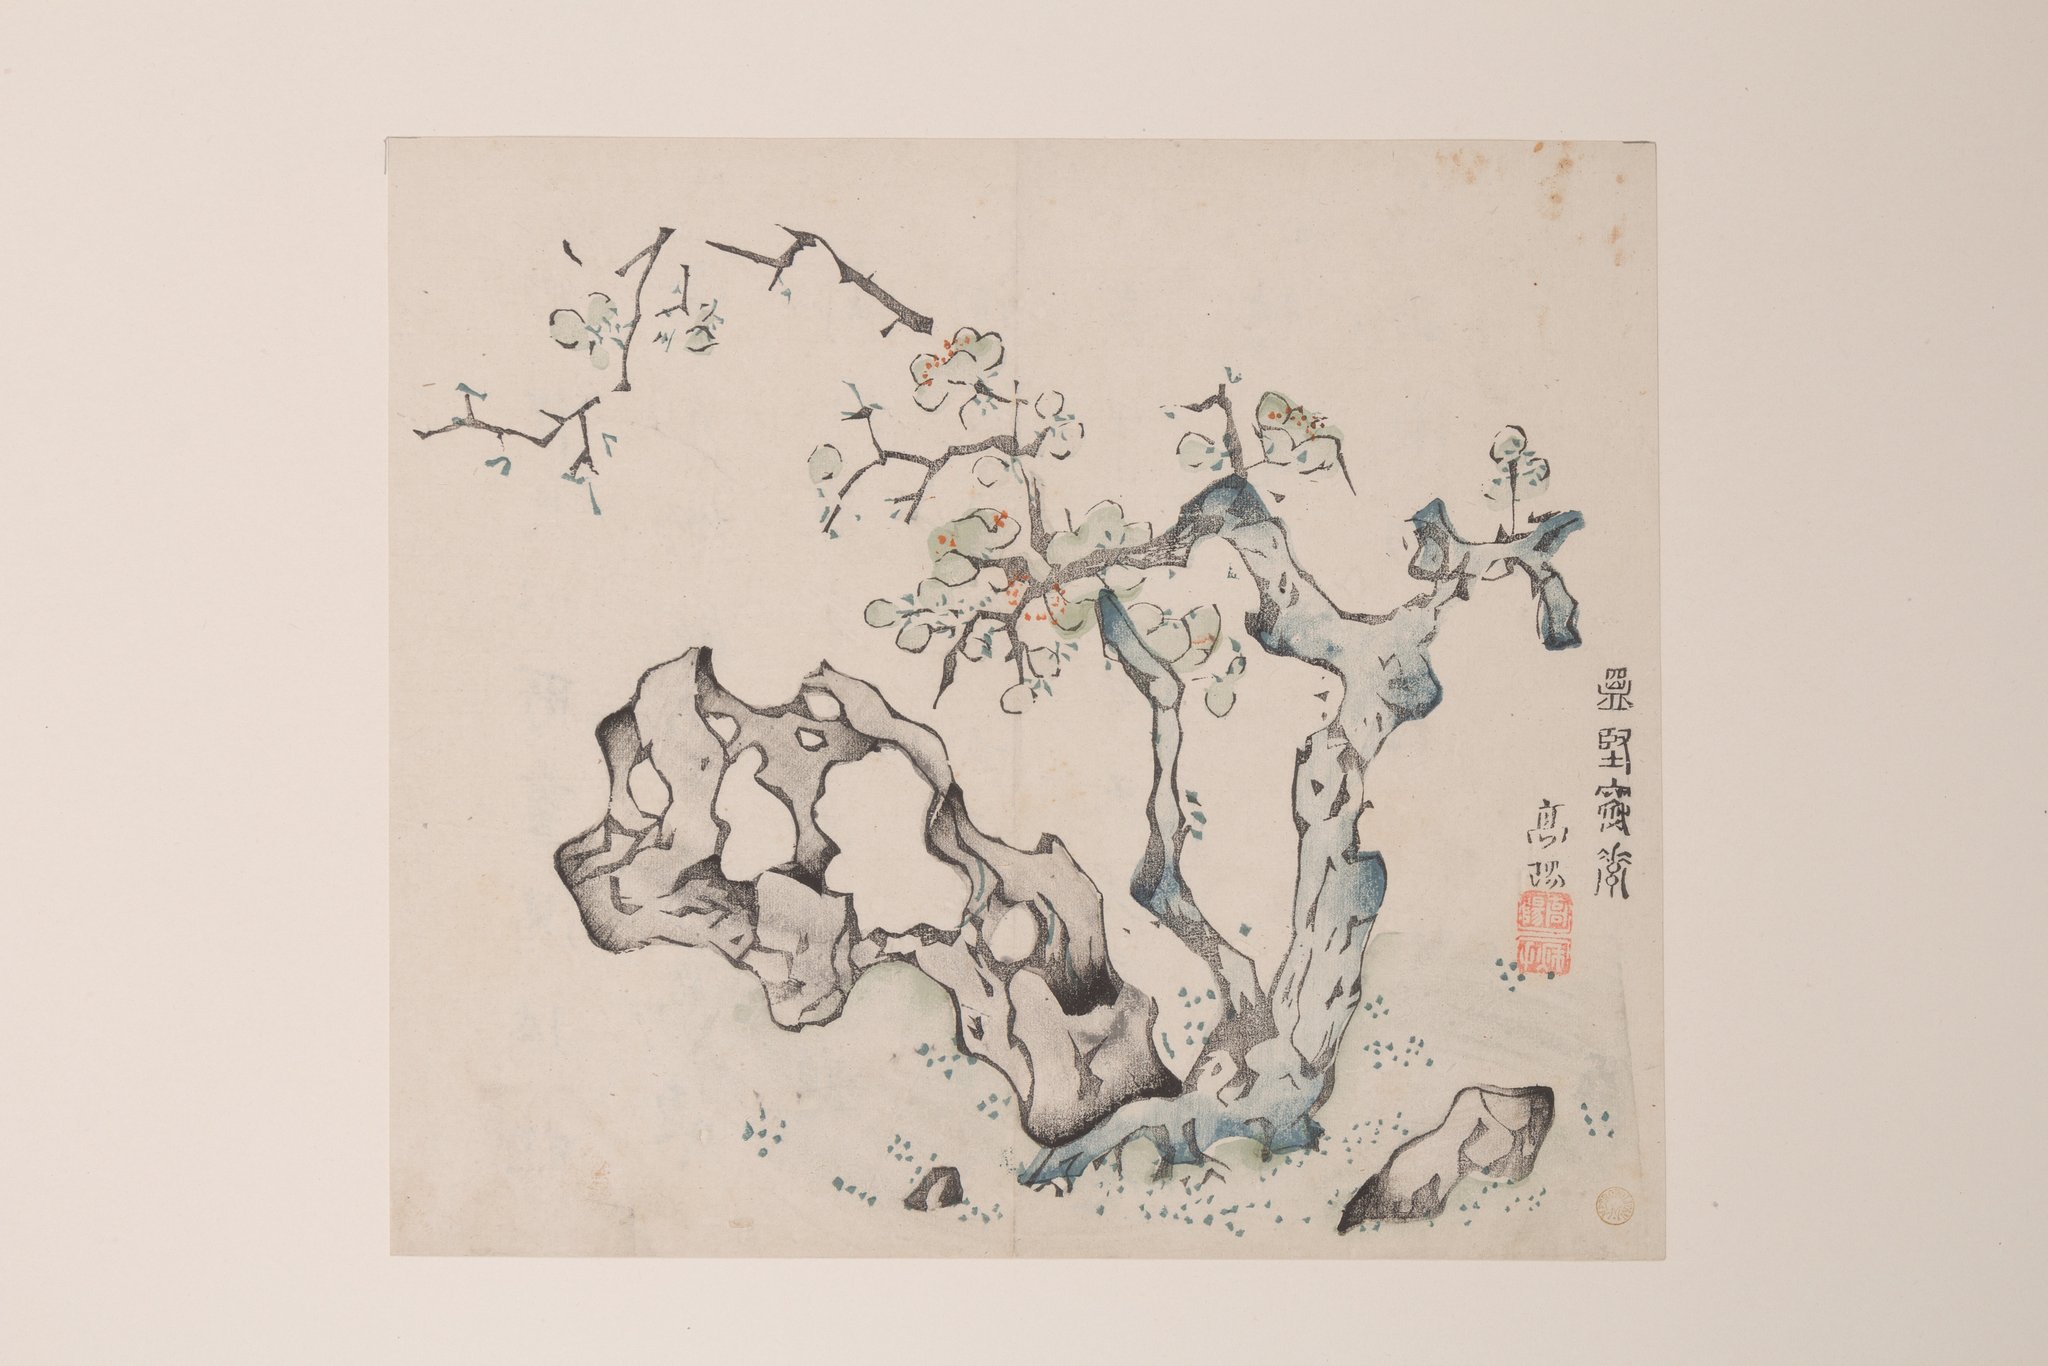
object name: print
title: Page from the Ten Bamboo Studio Manual of Painting and Calligraphy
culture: chinese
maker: hu zhengyan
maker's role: artist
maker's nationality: chinese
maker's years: 1584-1634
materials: ink, paper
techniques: printing